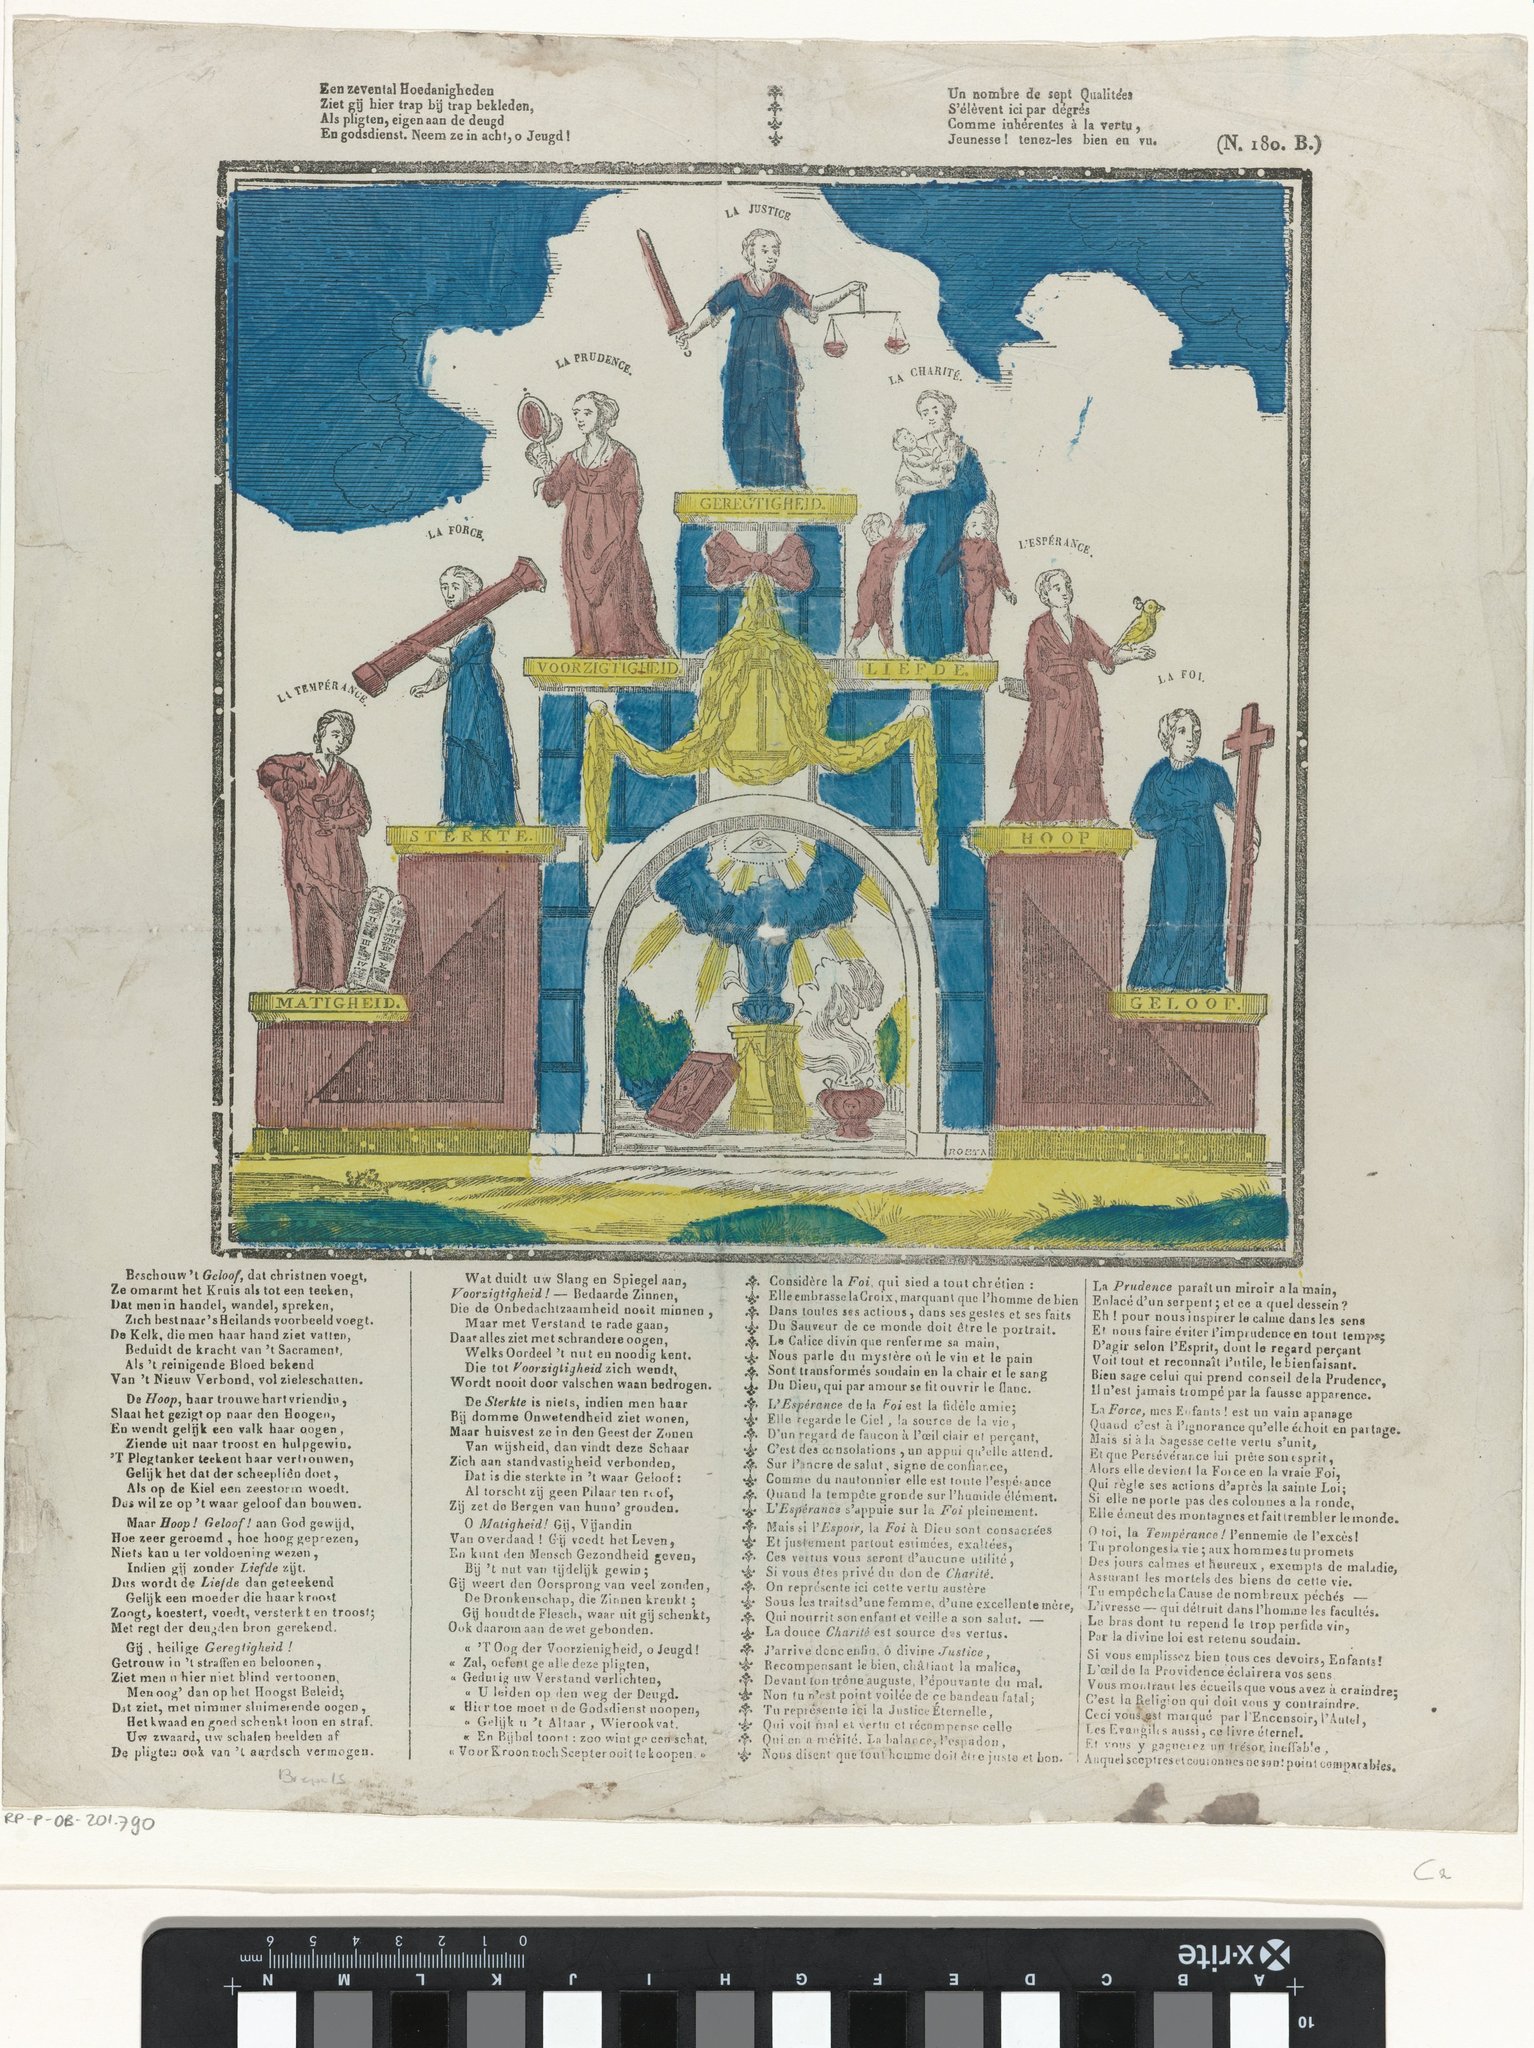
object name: popular print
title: Een zevental hoedanigheden / Ziet gij hier trap bij trap bekleden [(...)]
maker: philippus jacobus brepols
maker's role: printer, publisher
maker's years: 1778-1845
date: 1800-1833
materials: paper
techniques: colour, letterpress printing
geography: turnhout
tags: ladder of virtues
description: Trap met op de zeven treden personificaties van de zeven deugden, matigheid, sterkte, voorzichtigheid, gerechtigheid, liefde, hoop en geloof. Onder de voorstelling een onderschrift in het Nederlands en in het Frans in vier kolommen. Genummerd rechtsboven: [N. 180. B.].